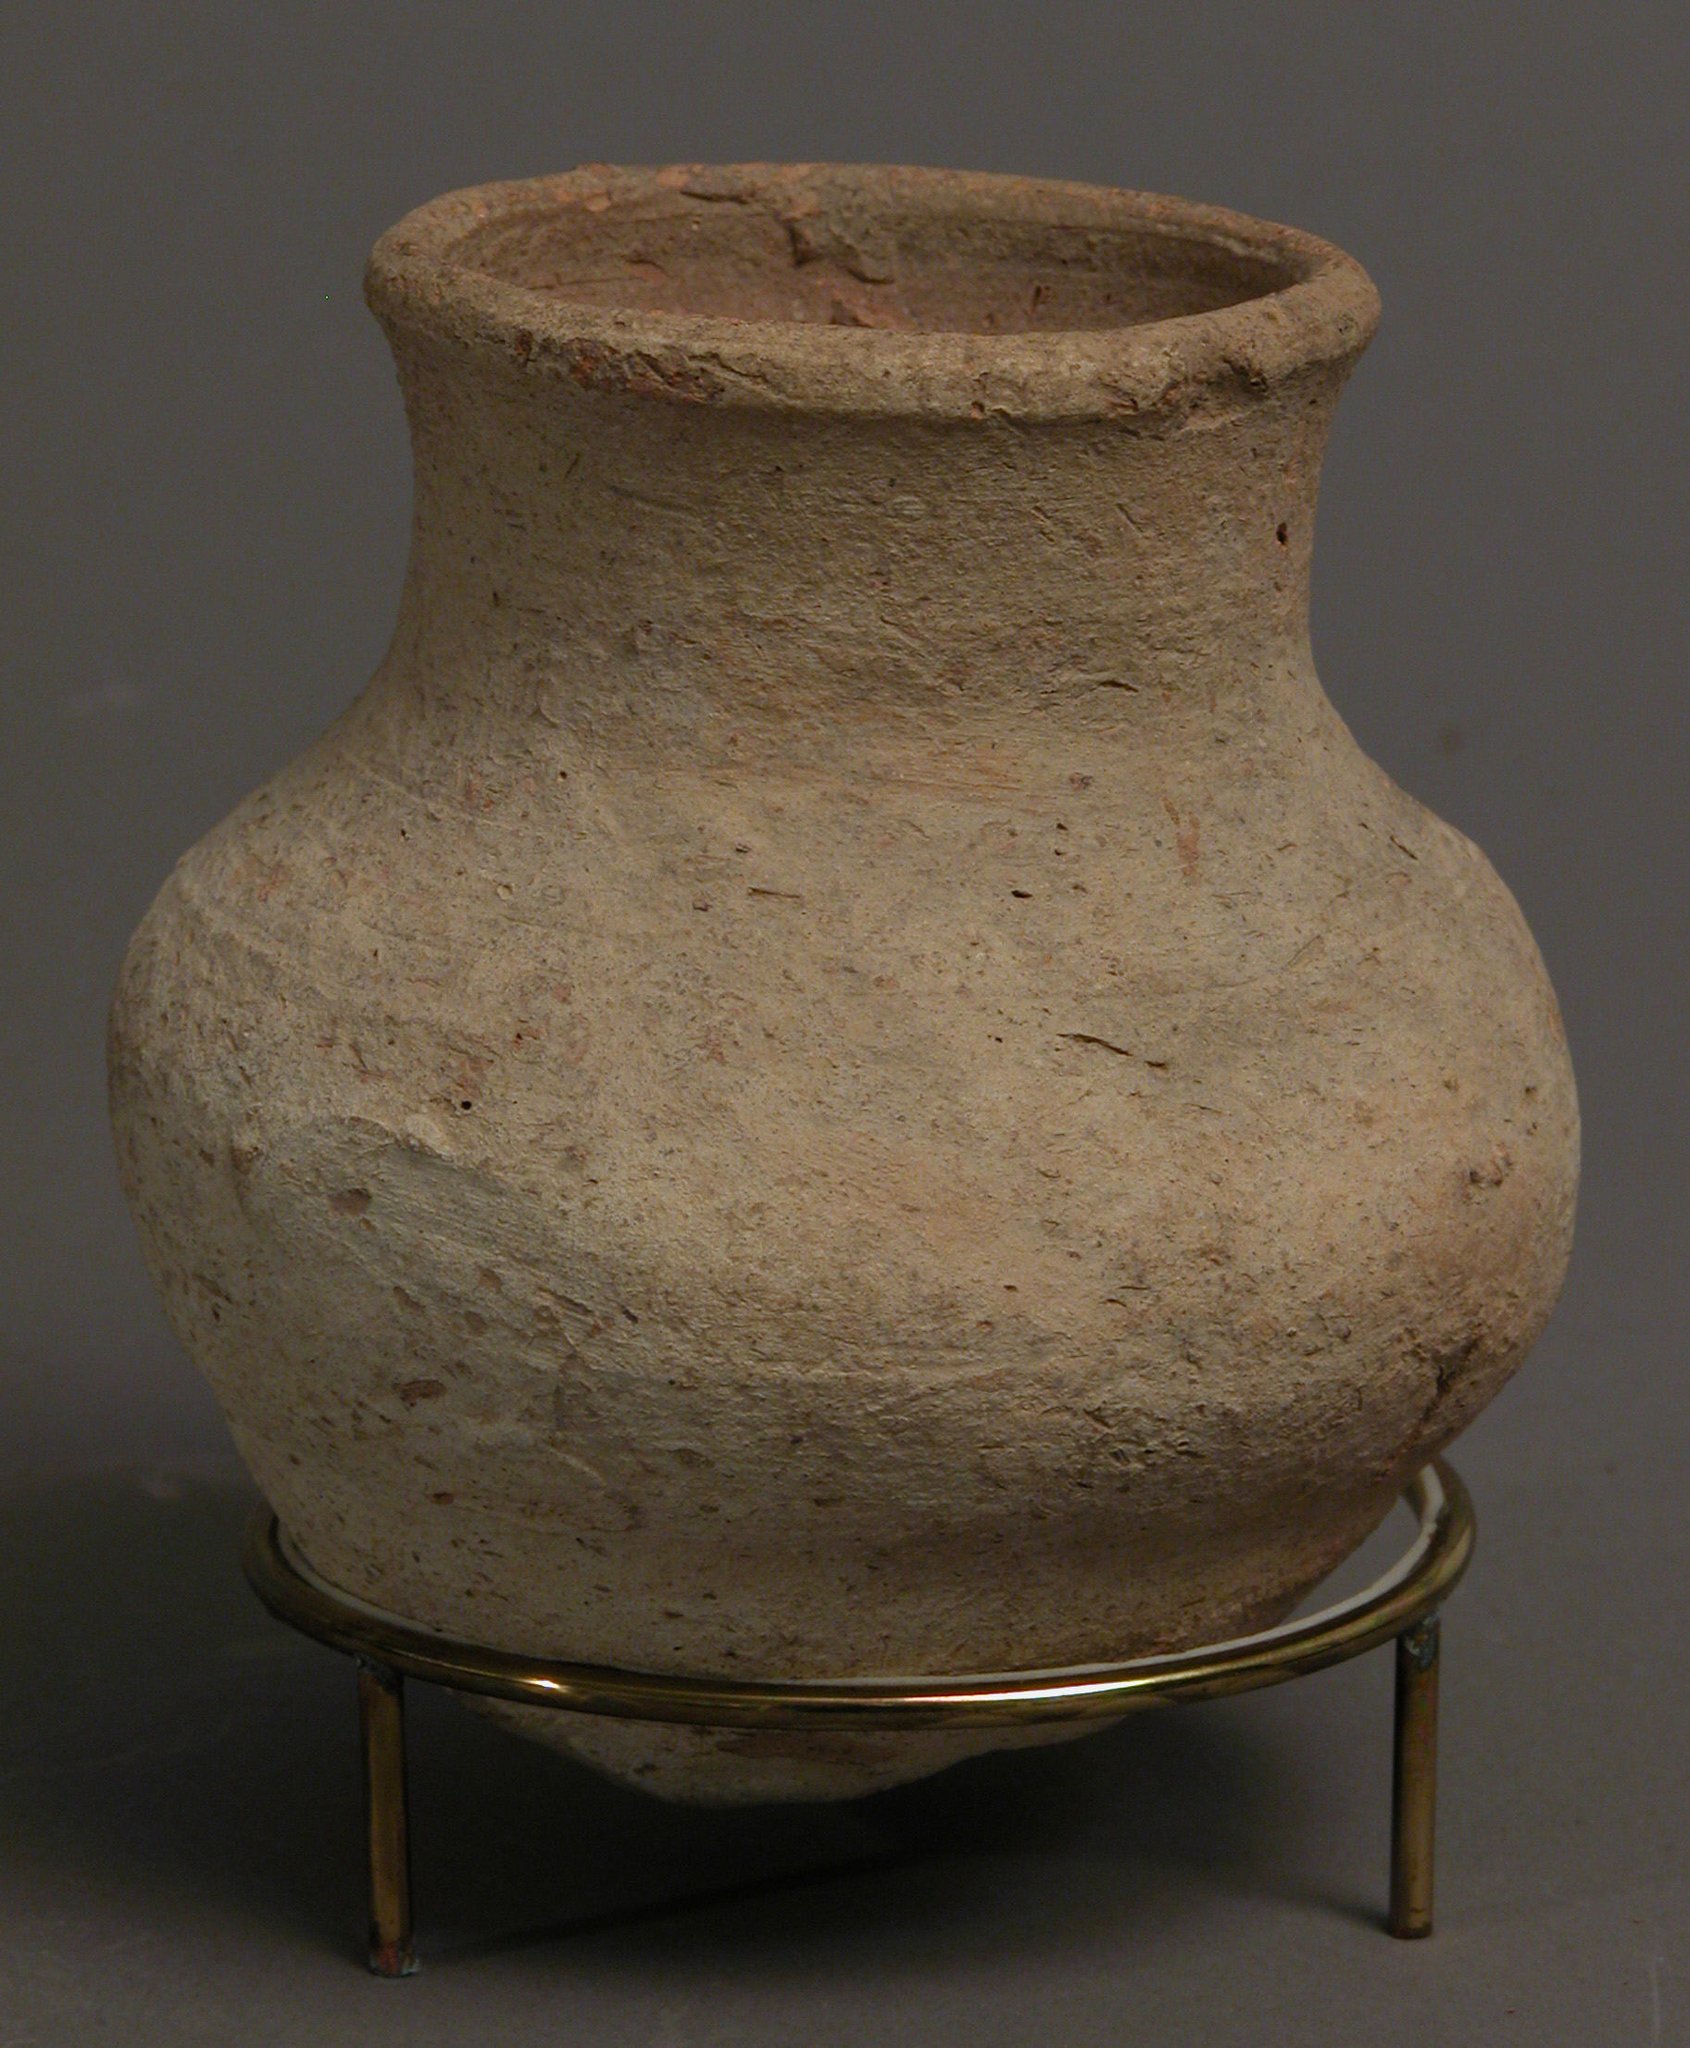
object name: pot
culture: coptic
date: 301-700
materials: earthenware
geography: egypt